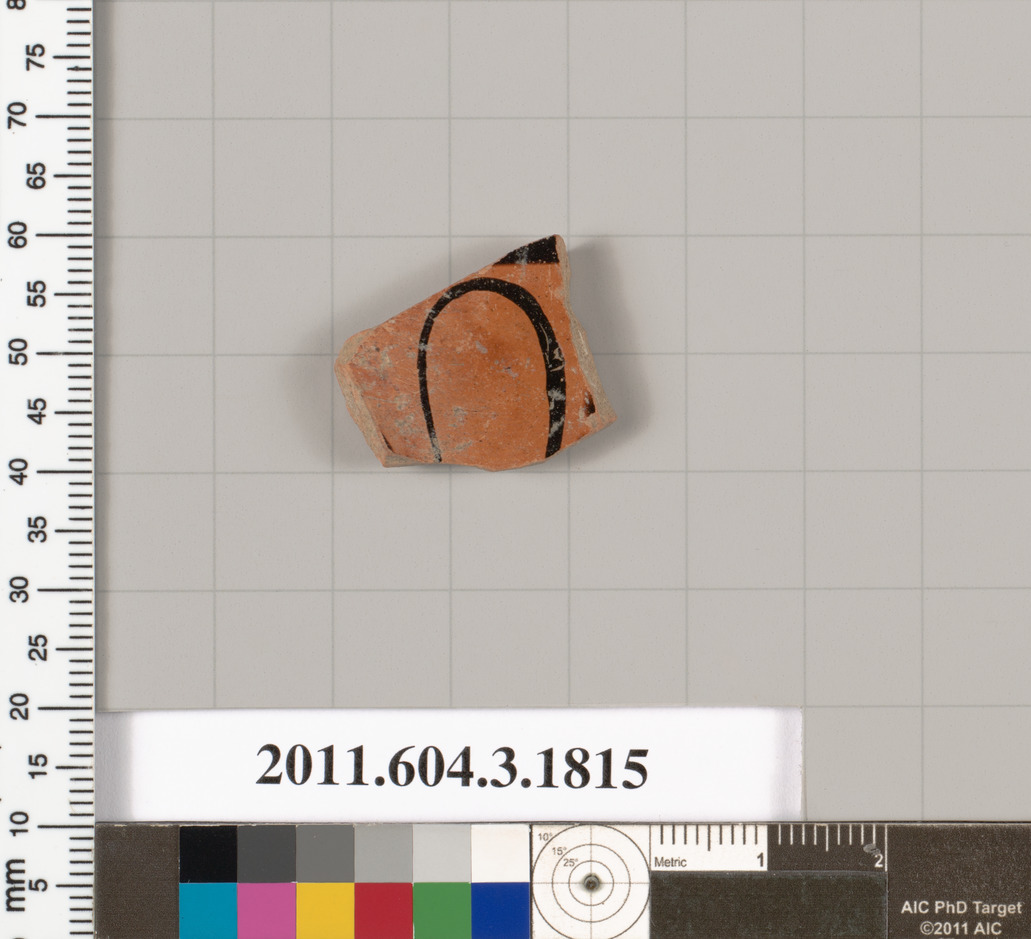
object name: kylix fragment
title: Terracotta fragment of a kylix: Lip cup (drinking cup)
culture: greek, attic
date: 550-526 BCE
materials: terracotta